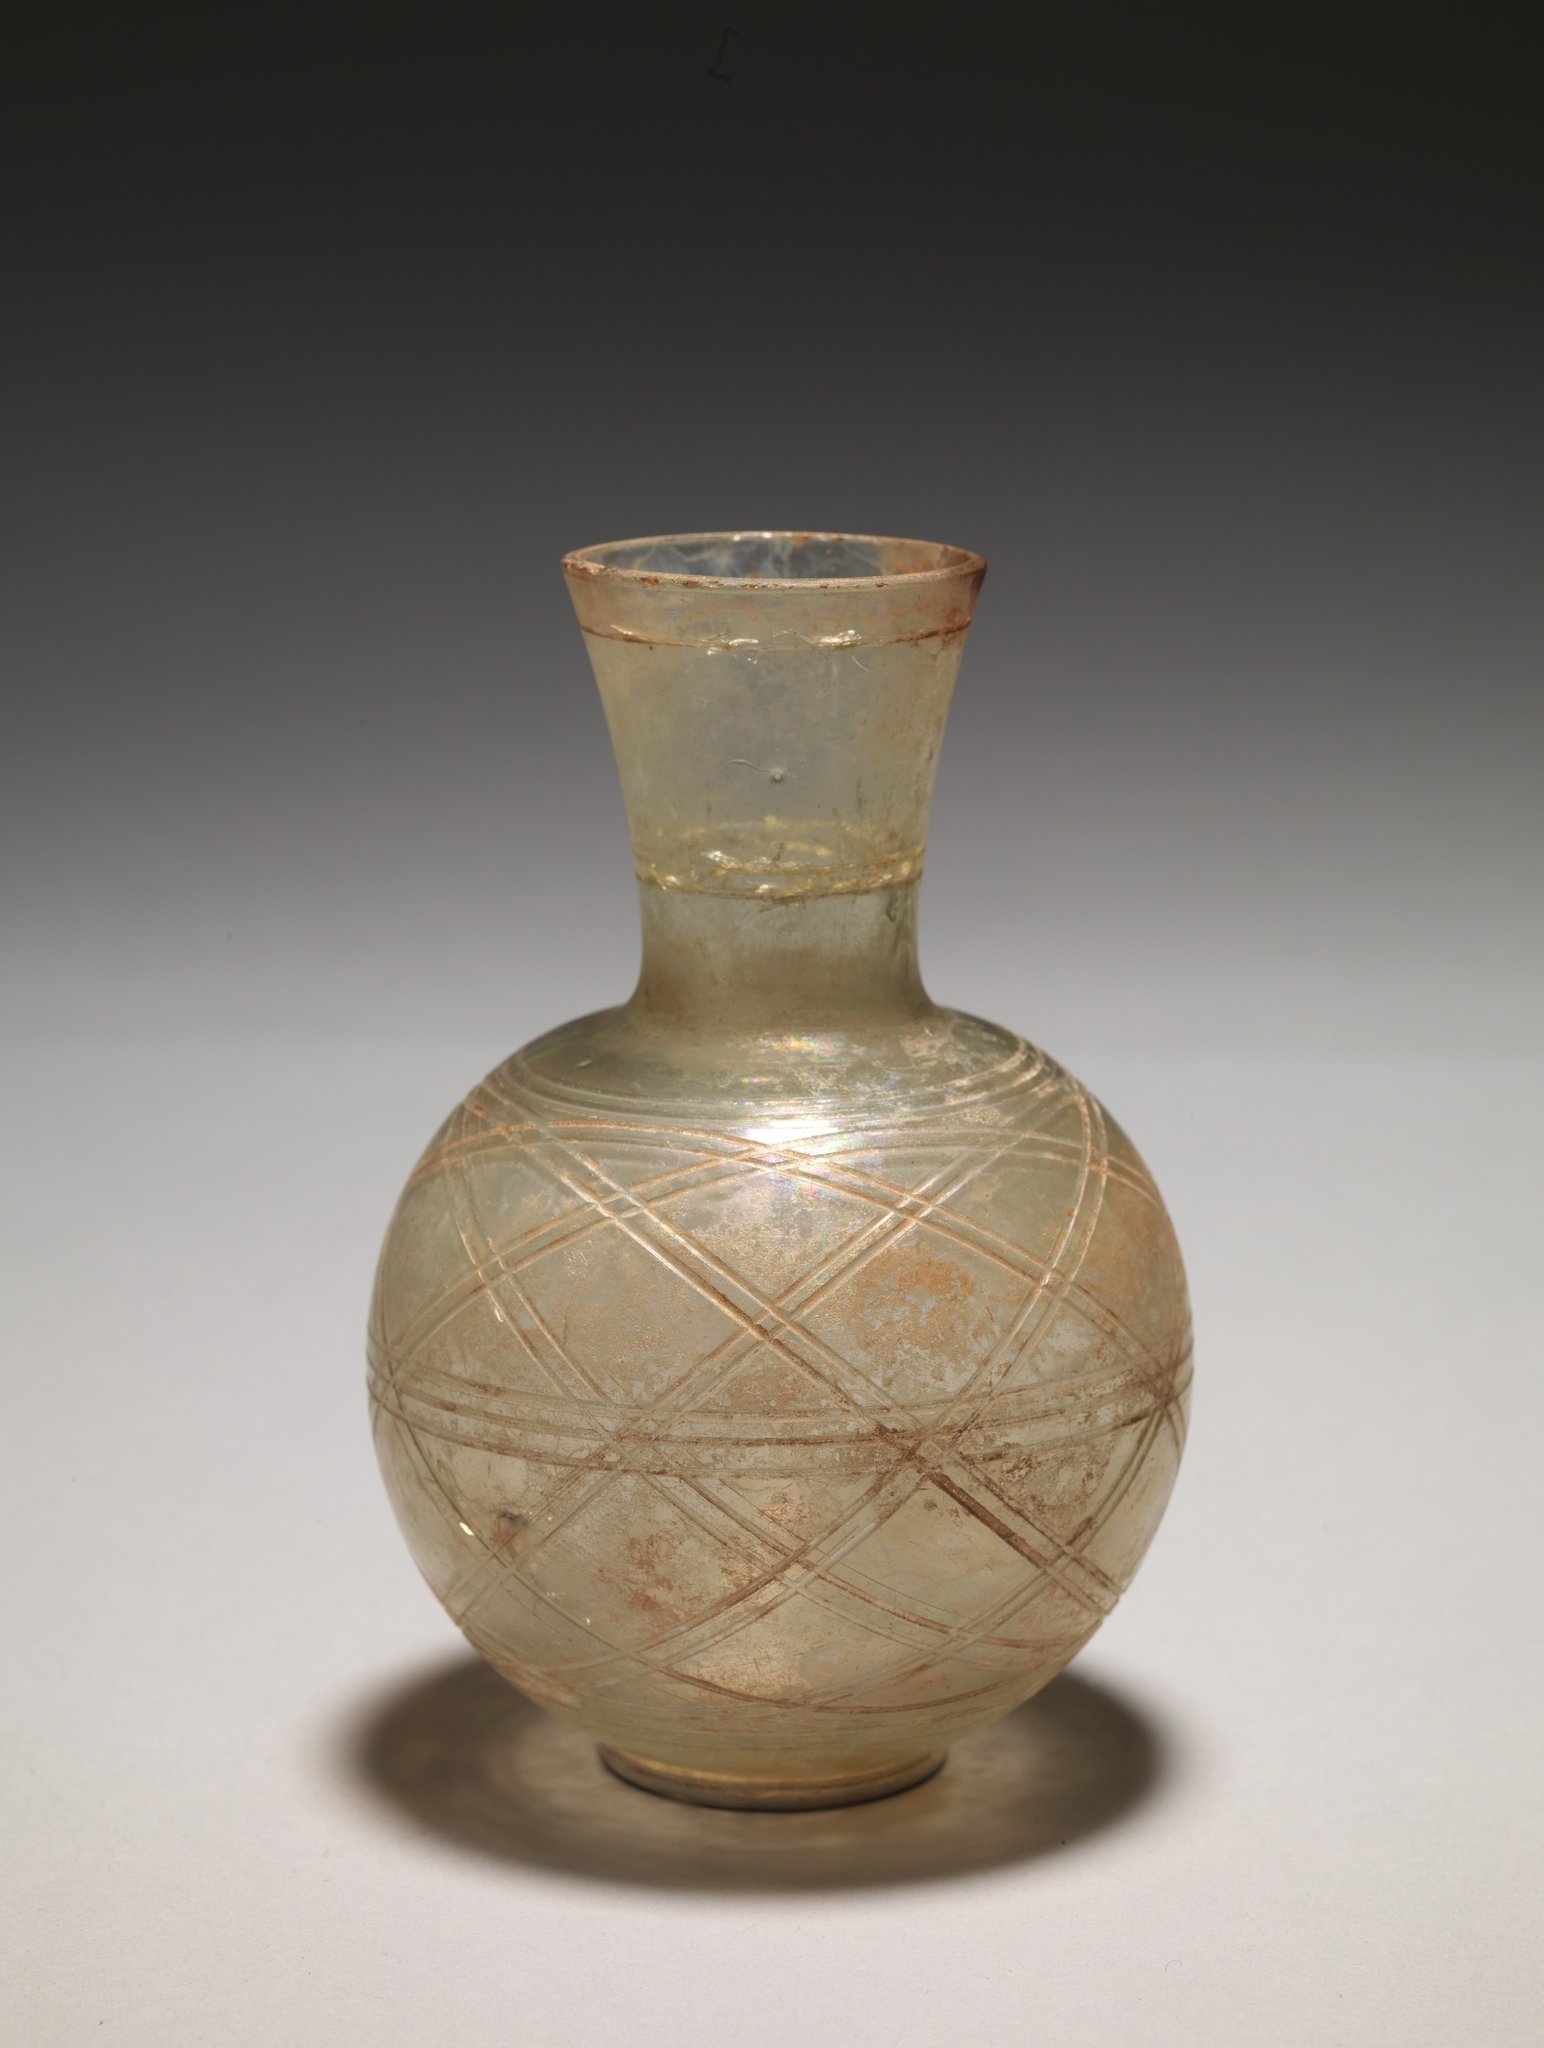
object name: bottle with engraved line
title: Glass flask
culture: roman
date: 301-400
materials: glass